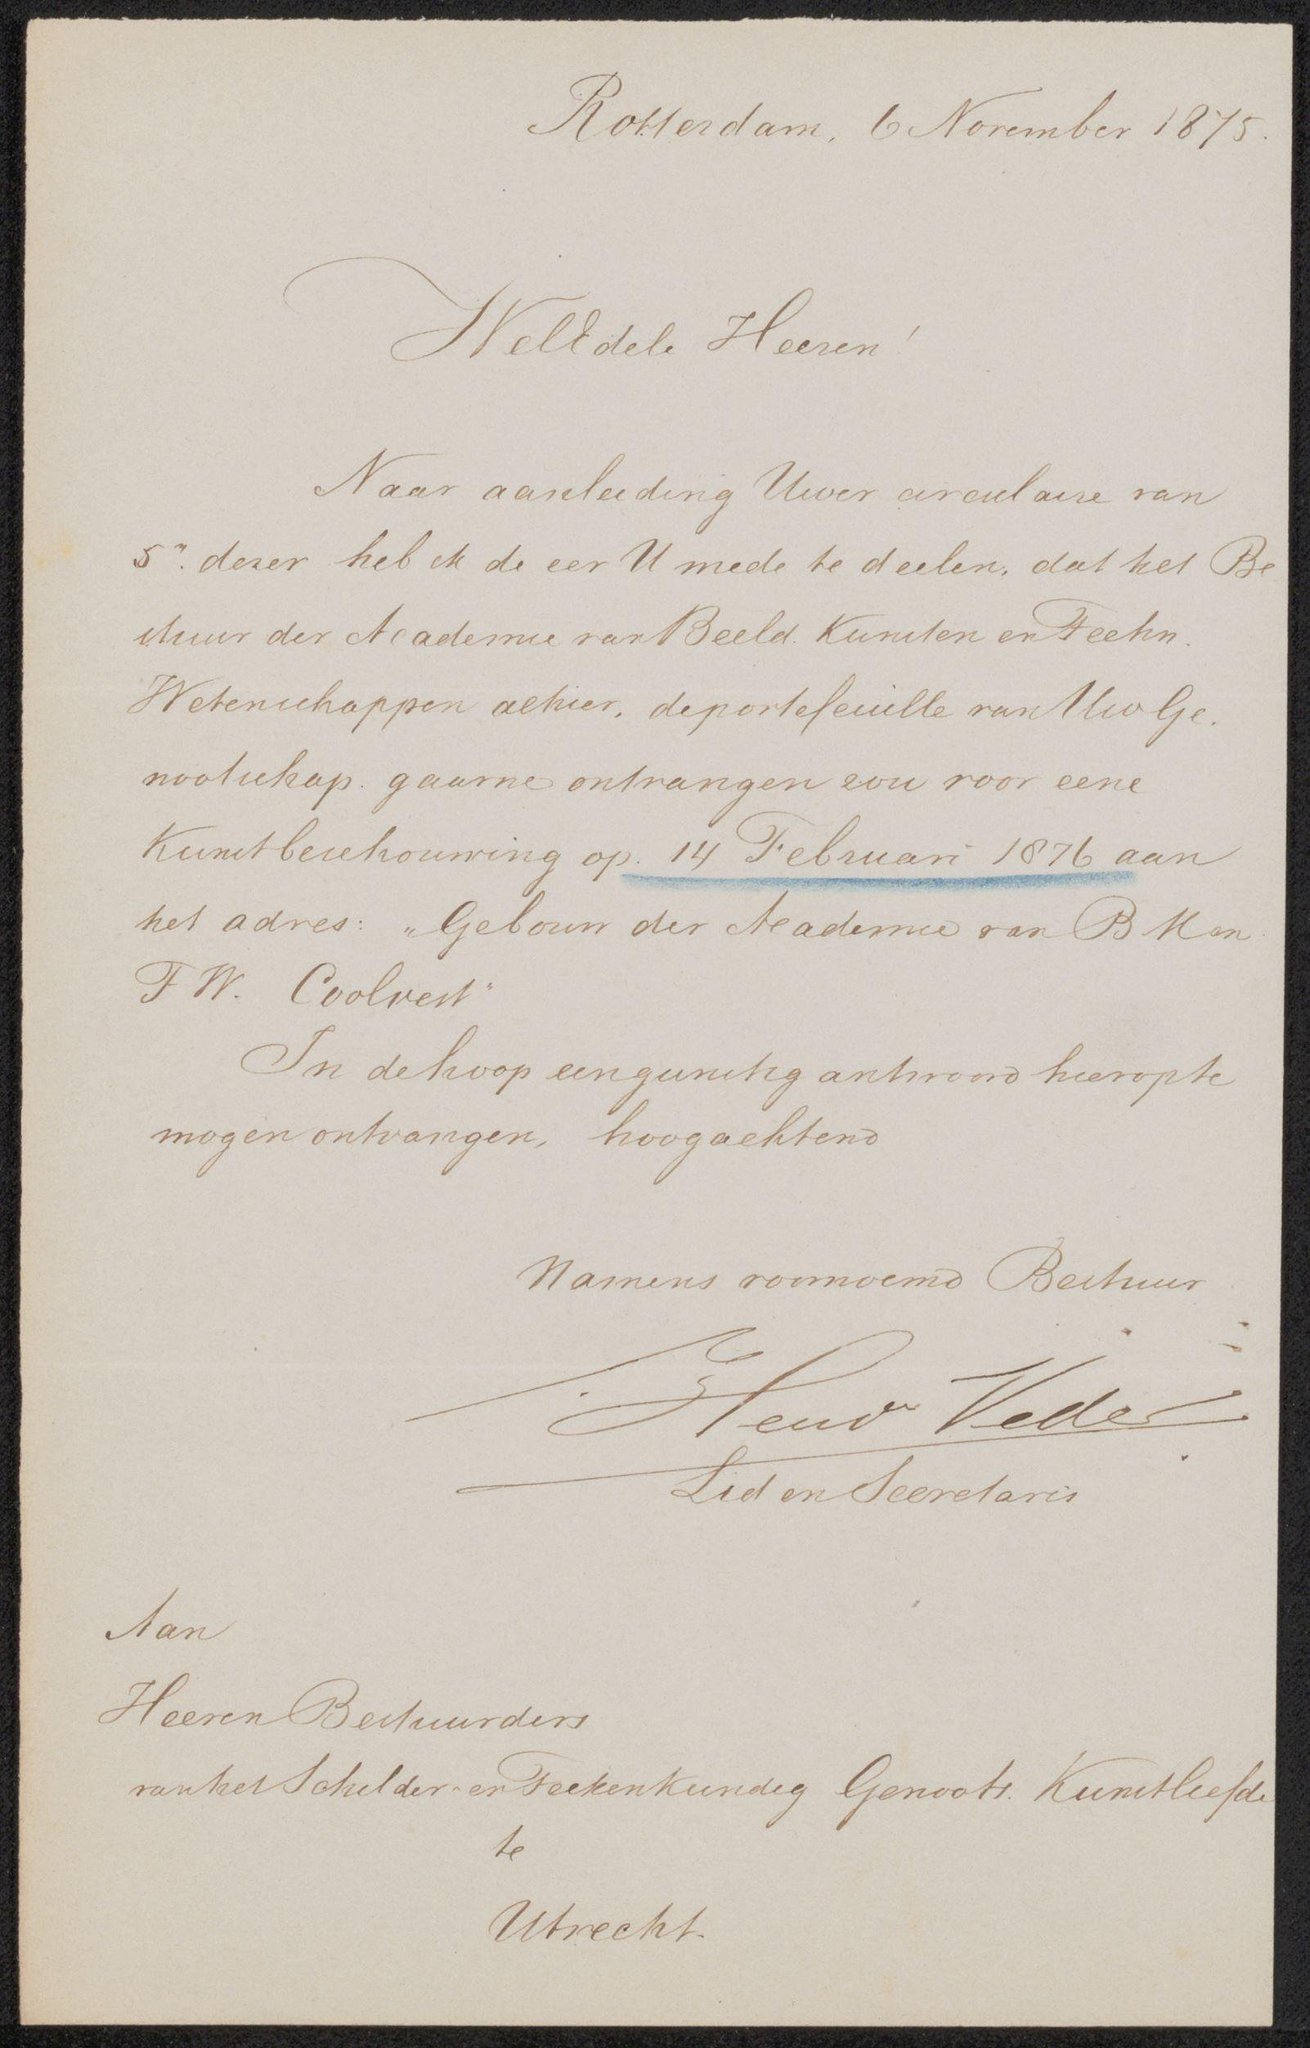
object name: letter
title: Brief aan Genootschap Kunstliefde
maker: hendrik veder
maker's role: draughtsman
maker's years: 1841-1894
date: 1875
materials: ink, paper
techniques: pen, writing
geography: rotterdam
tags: criticizing and discussing art, art criticism